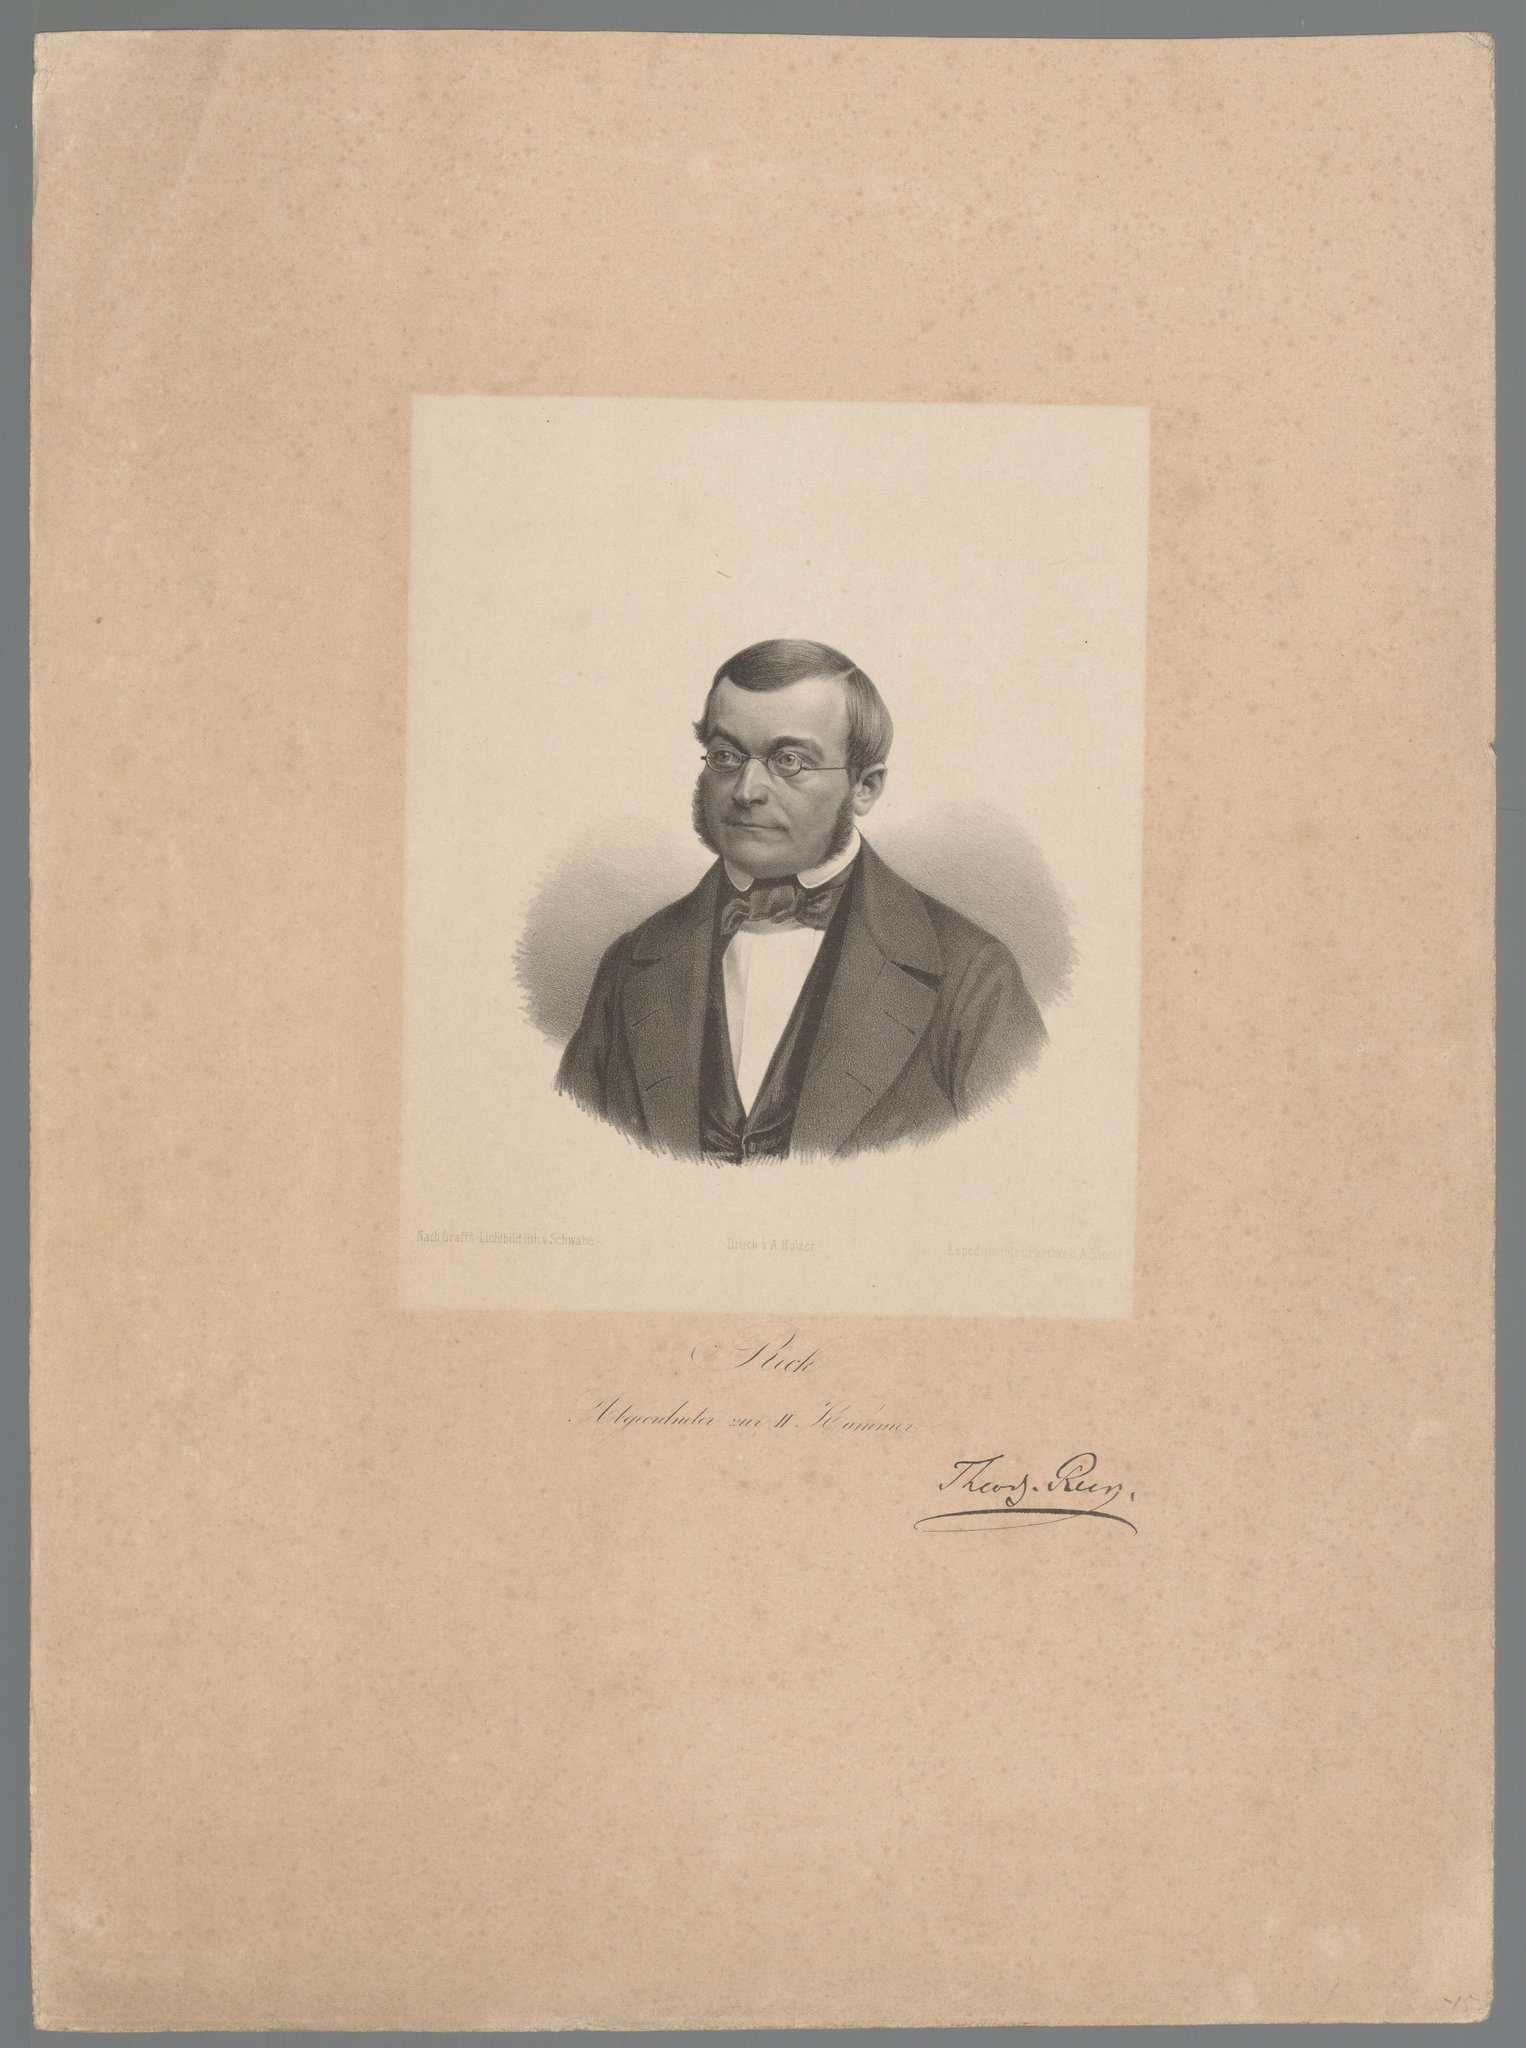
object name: print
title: Expedition des Pantheon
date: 1830-1860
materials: paper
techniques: lithograph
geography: berlin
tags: eyeglasses, spectacles, adult man, historical persons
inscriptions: collector's mark: Lugt 2228